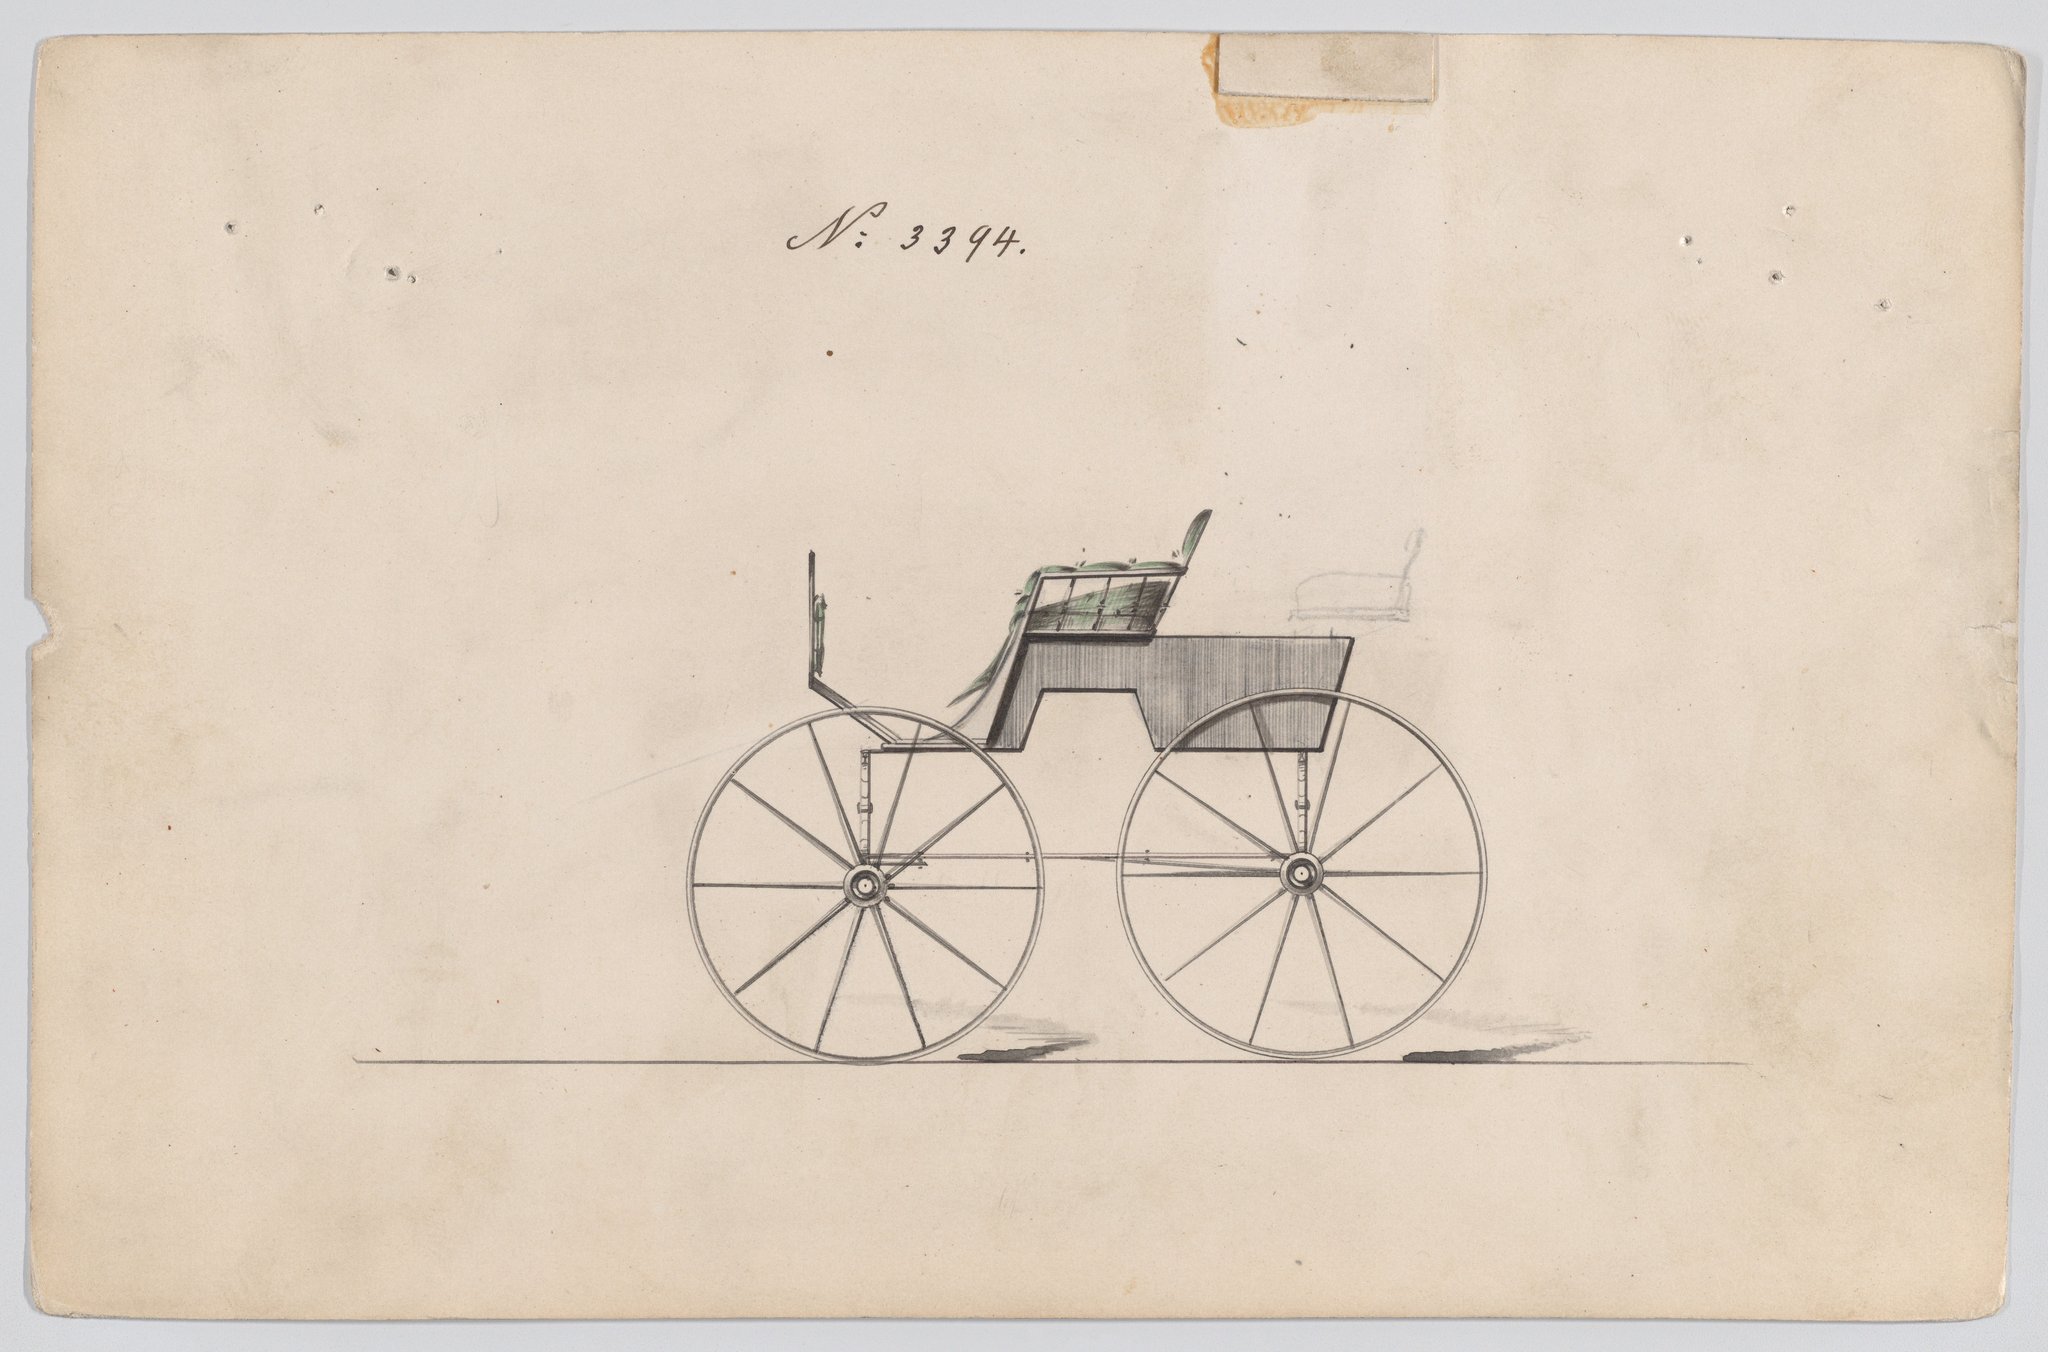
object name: drawing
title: Design for T-Cart, no. 3394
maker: brewster & co.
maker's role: manufacturer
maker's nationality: american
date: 1878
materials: gouache, graphite, gum arabic, ink, watercolor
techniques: pen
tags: carriages